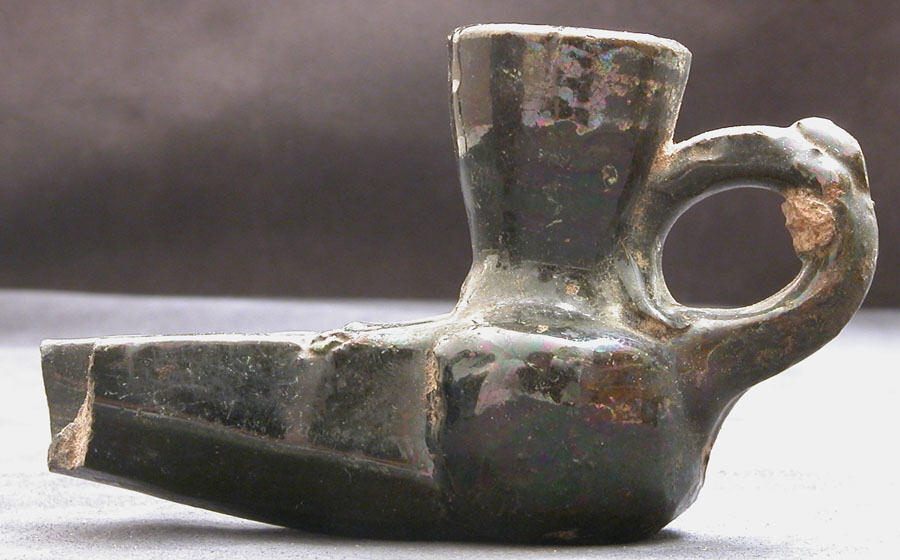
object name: lamp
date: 1101-1300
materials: earthenware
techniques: glazing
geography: syria